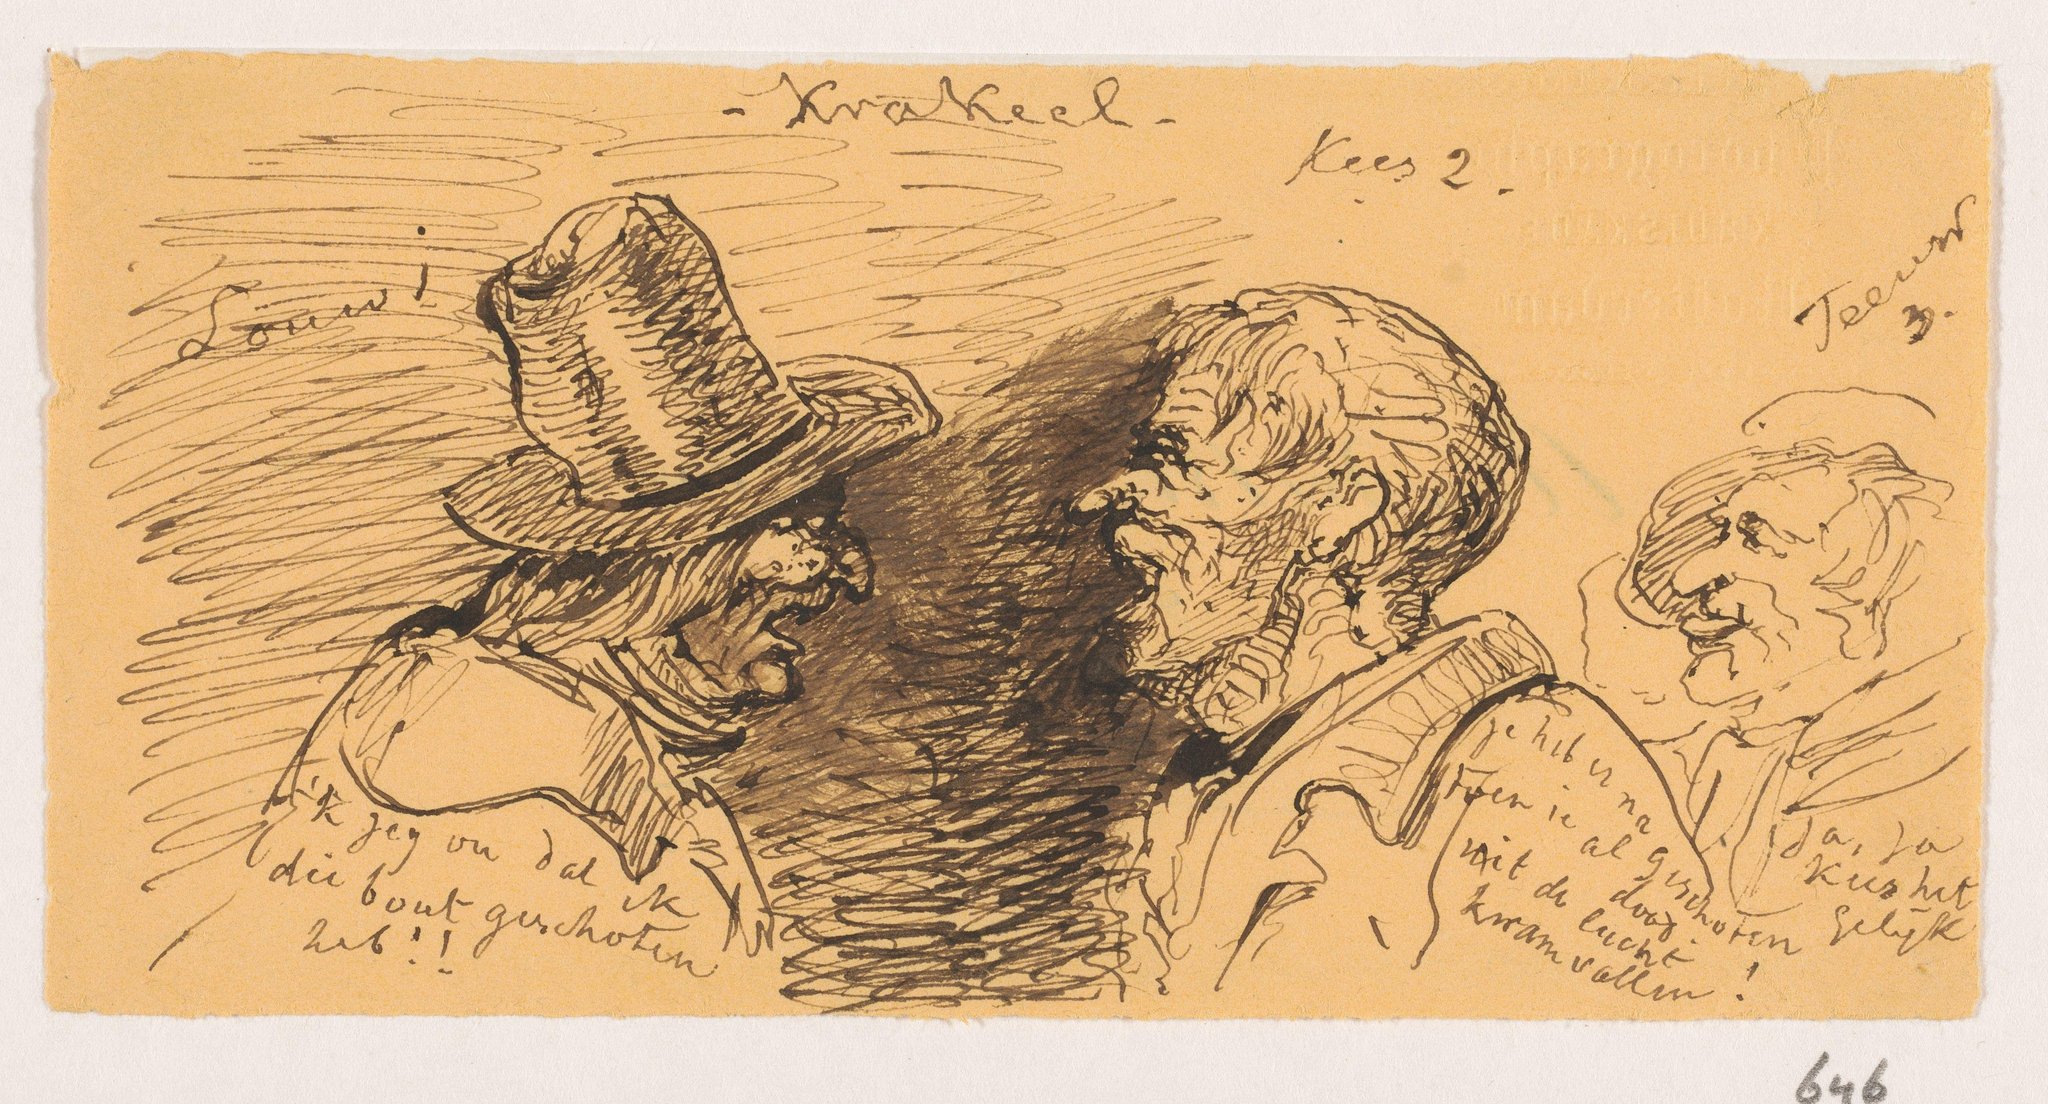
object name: drawing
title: Krakeel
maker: johannes tavenraat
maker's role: draughtsman, painter, print maker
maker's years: 1809-1881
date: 1840-1880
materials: ink, paper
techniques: pen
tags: hunter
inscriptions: collector's mark: Lugt 2228, annotation: ‘Krakeel / Louw 1 / Kees 2 / Teeuw 3 ...’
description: Drie mannen met elkaar in gesprek over een geschoten haas. Getekend op de achterzijde van een deel van een envelop gericht aan J. Tavenraat.